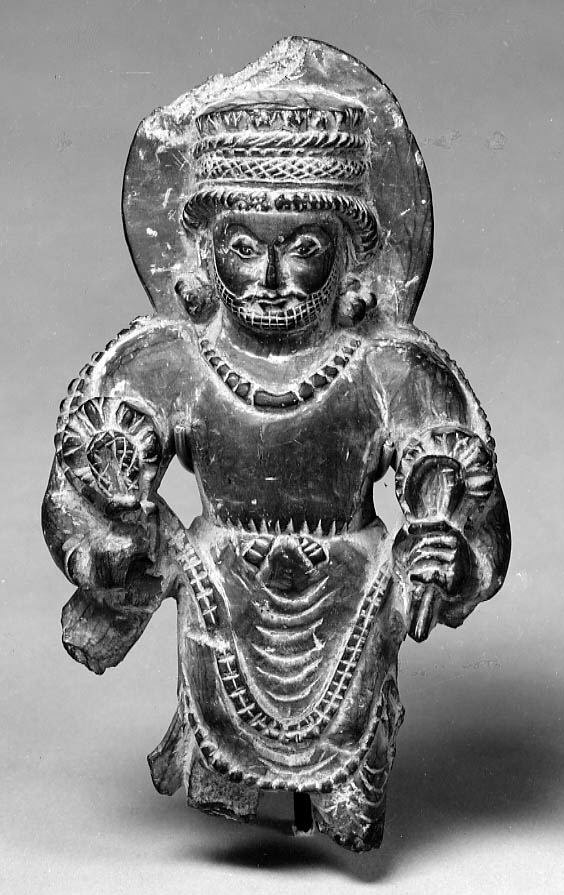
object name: figure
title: Standing Surya (The God of the Sun)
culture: kashmiri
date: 501-600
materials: stone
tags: kashmir,hinduism